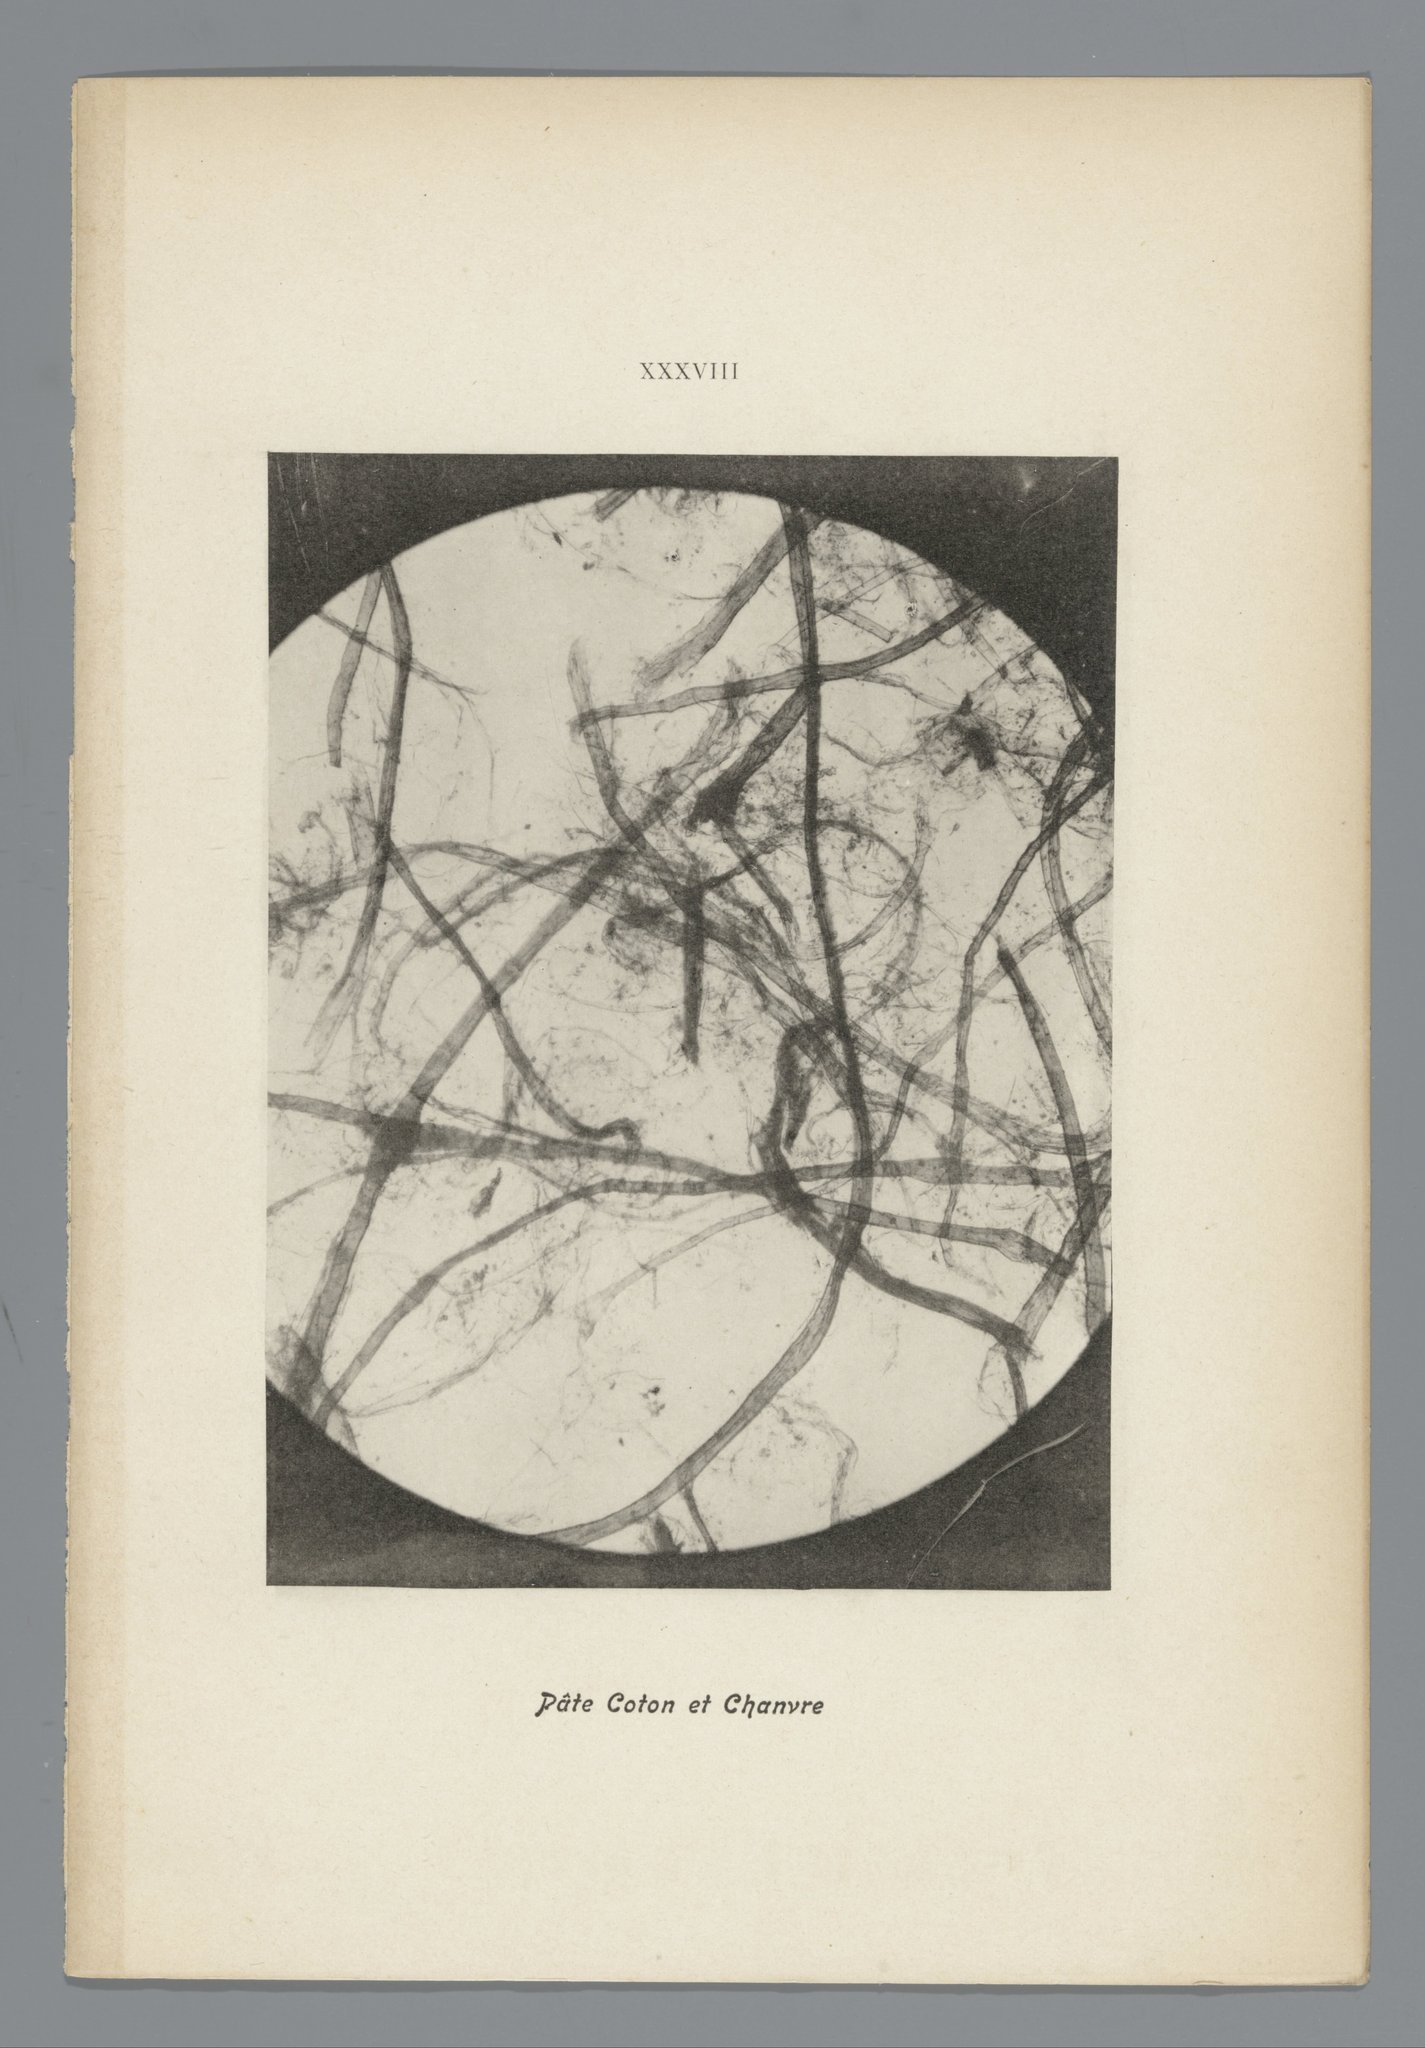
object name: photograph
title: XXXVIII Pâte Coton et Chanvre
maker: Anonymous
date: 1900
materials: ink, paper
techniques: photograph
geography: france